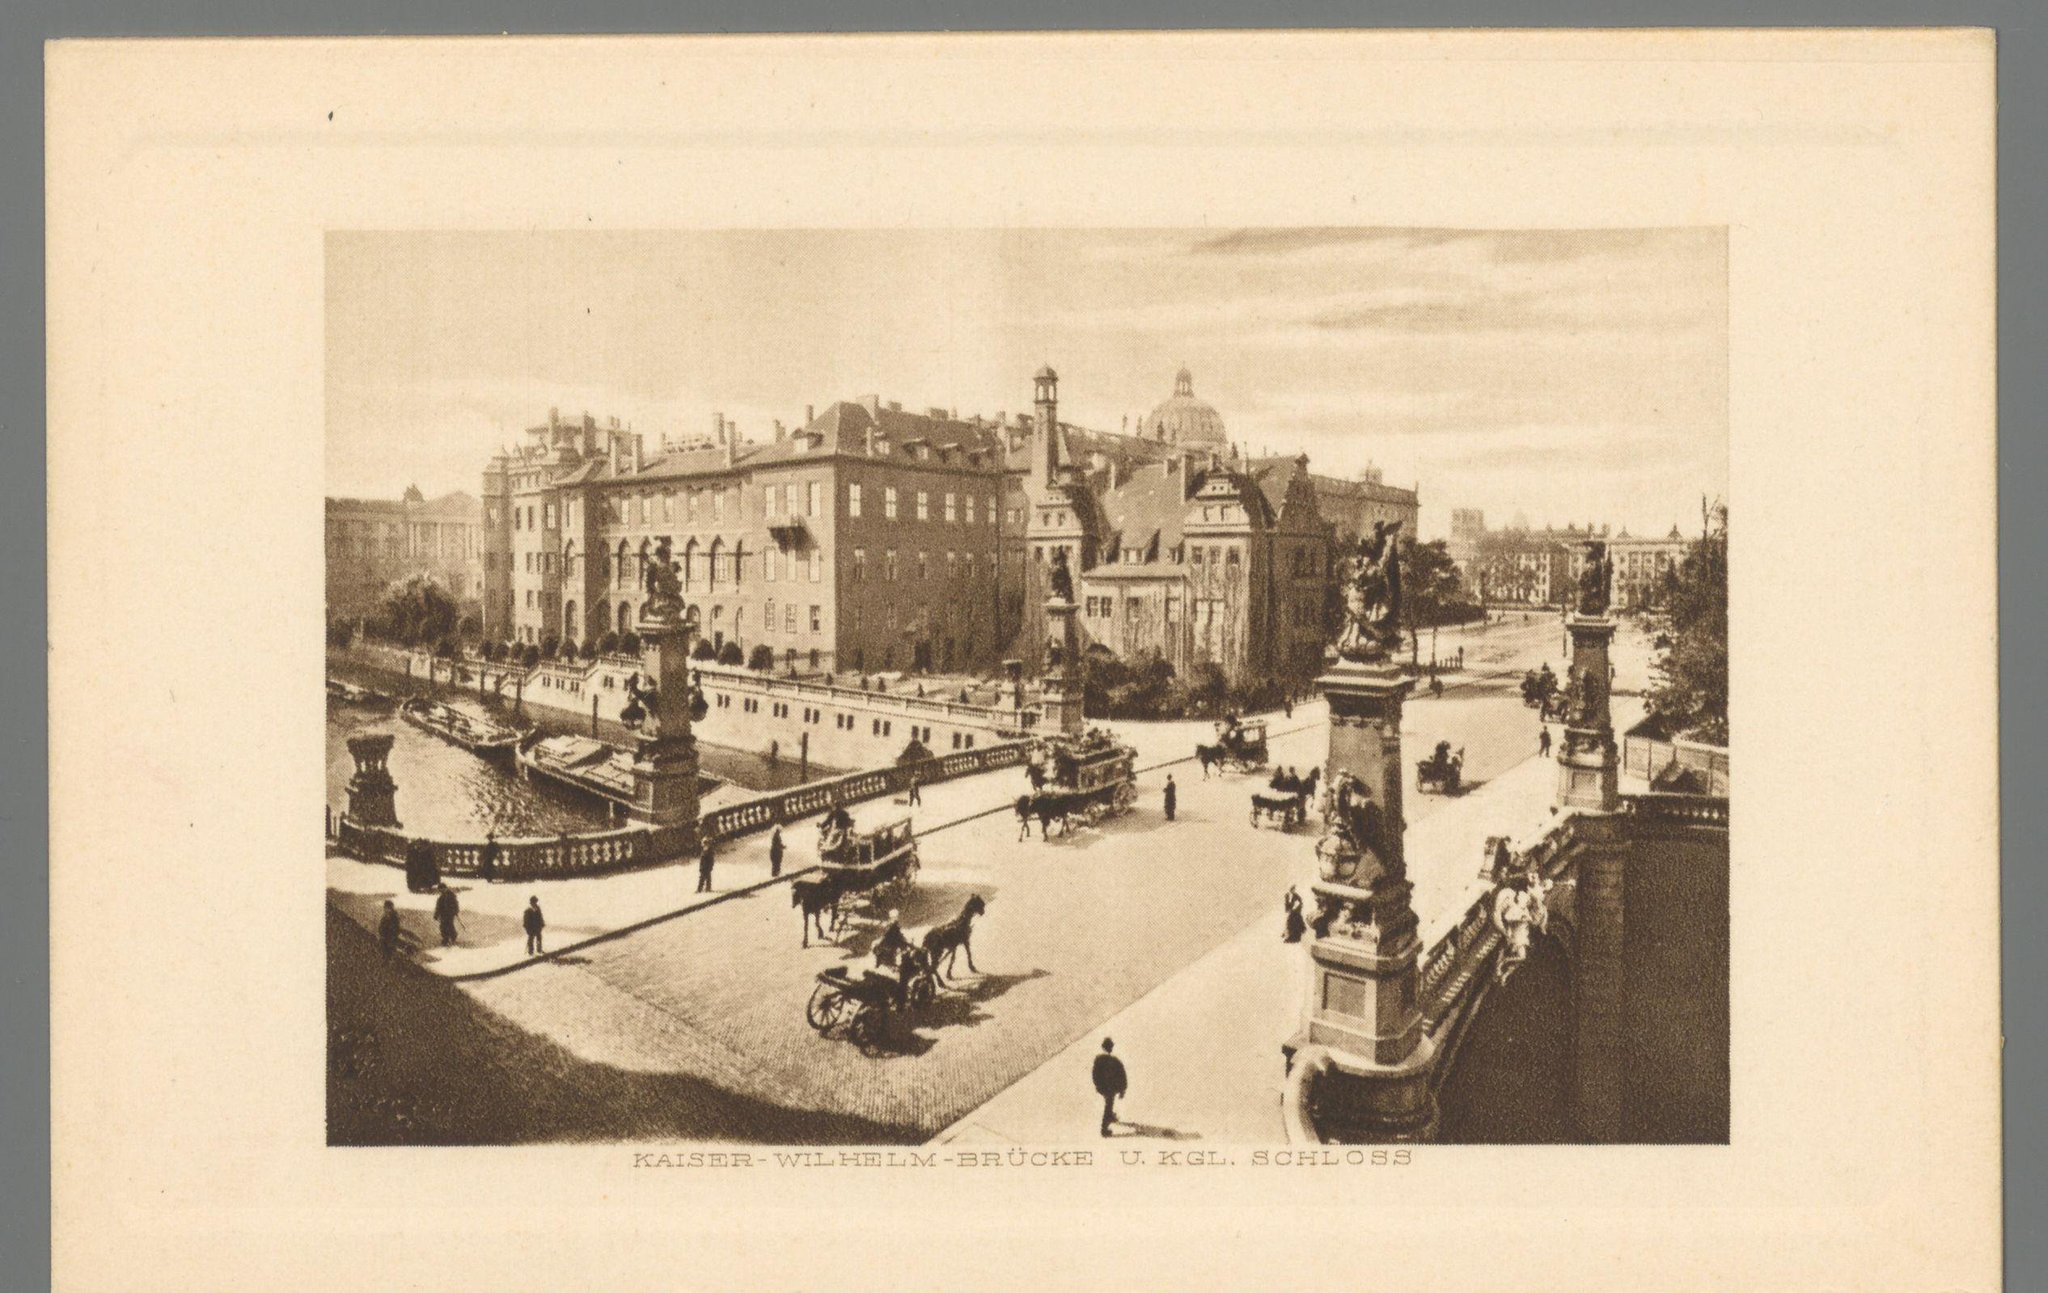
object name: photomechanical print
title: Kaiser-Wilhelm-Brücke u. Kgl. Schloss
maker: Anonymous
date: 1905-1909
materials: cardboard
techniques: rotogravure, writing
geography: berlin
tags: berlin, frederik willem iv (koning van pruisen), castle, bridge in city across river, canal, etc.